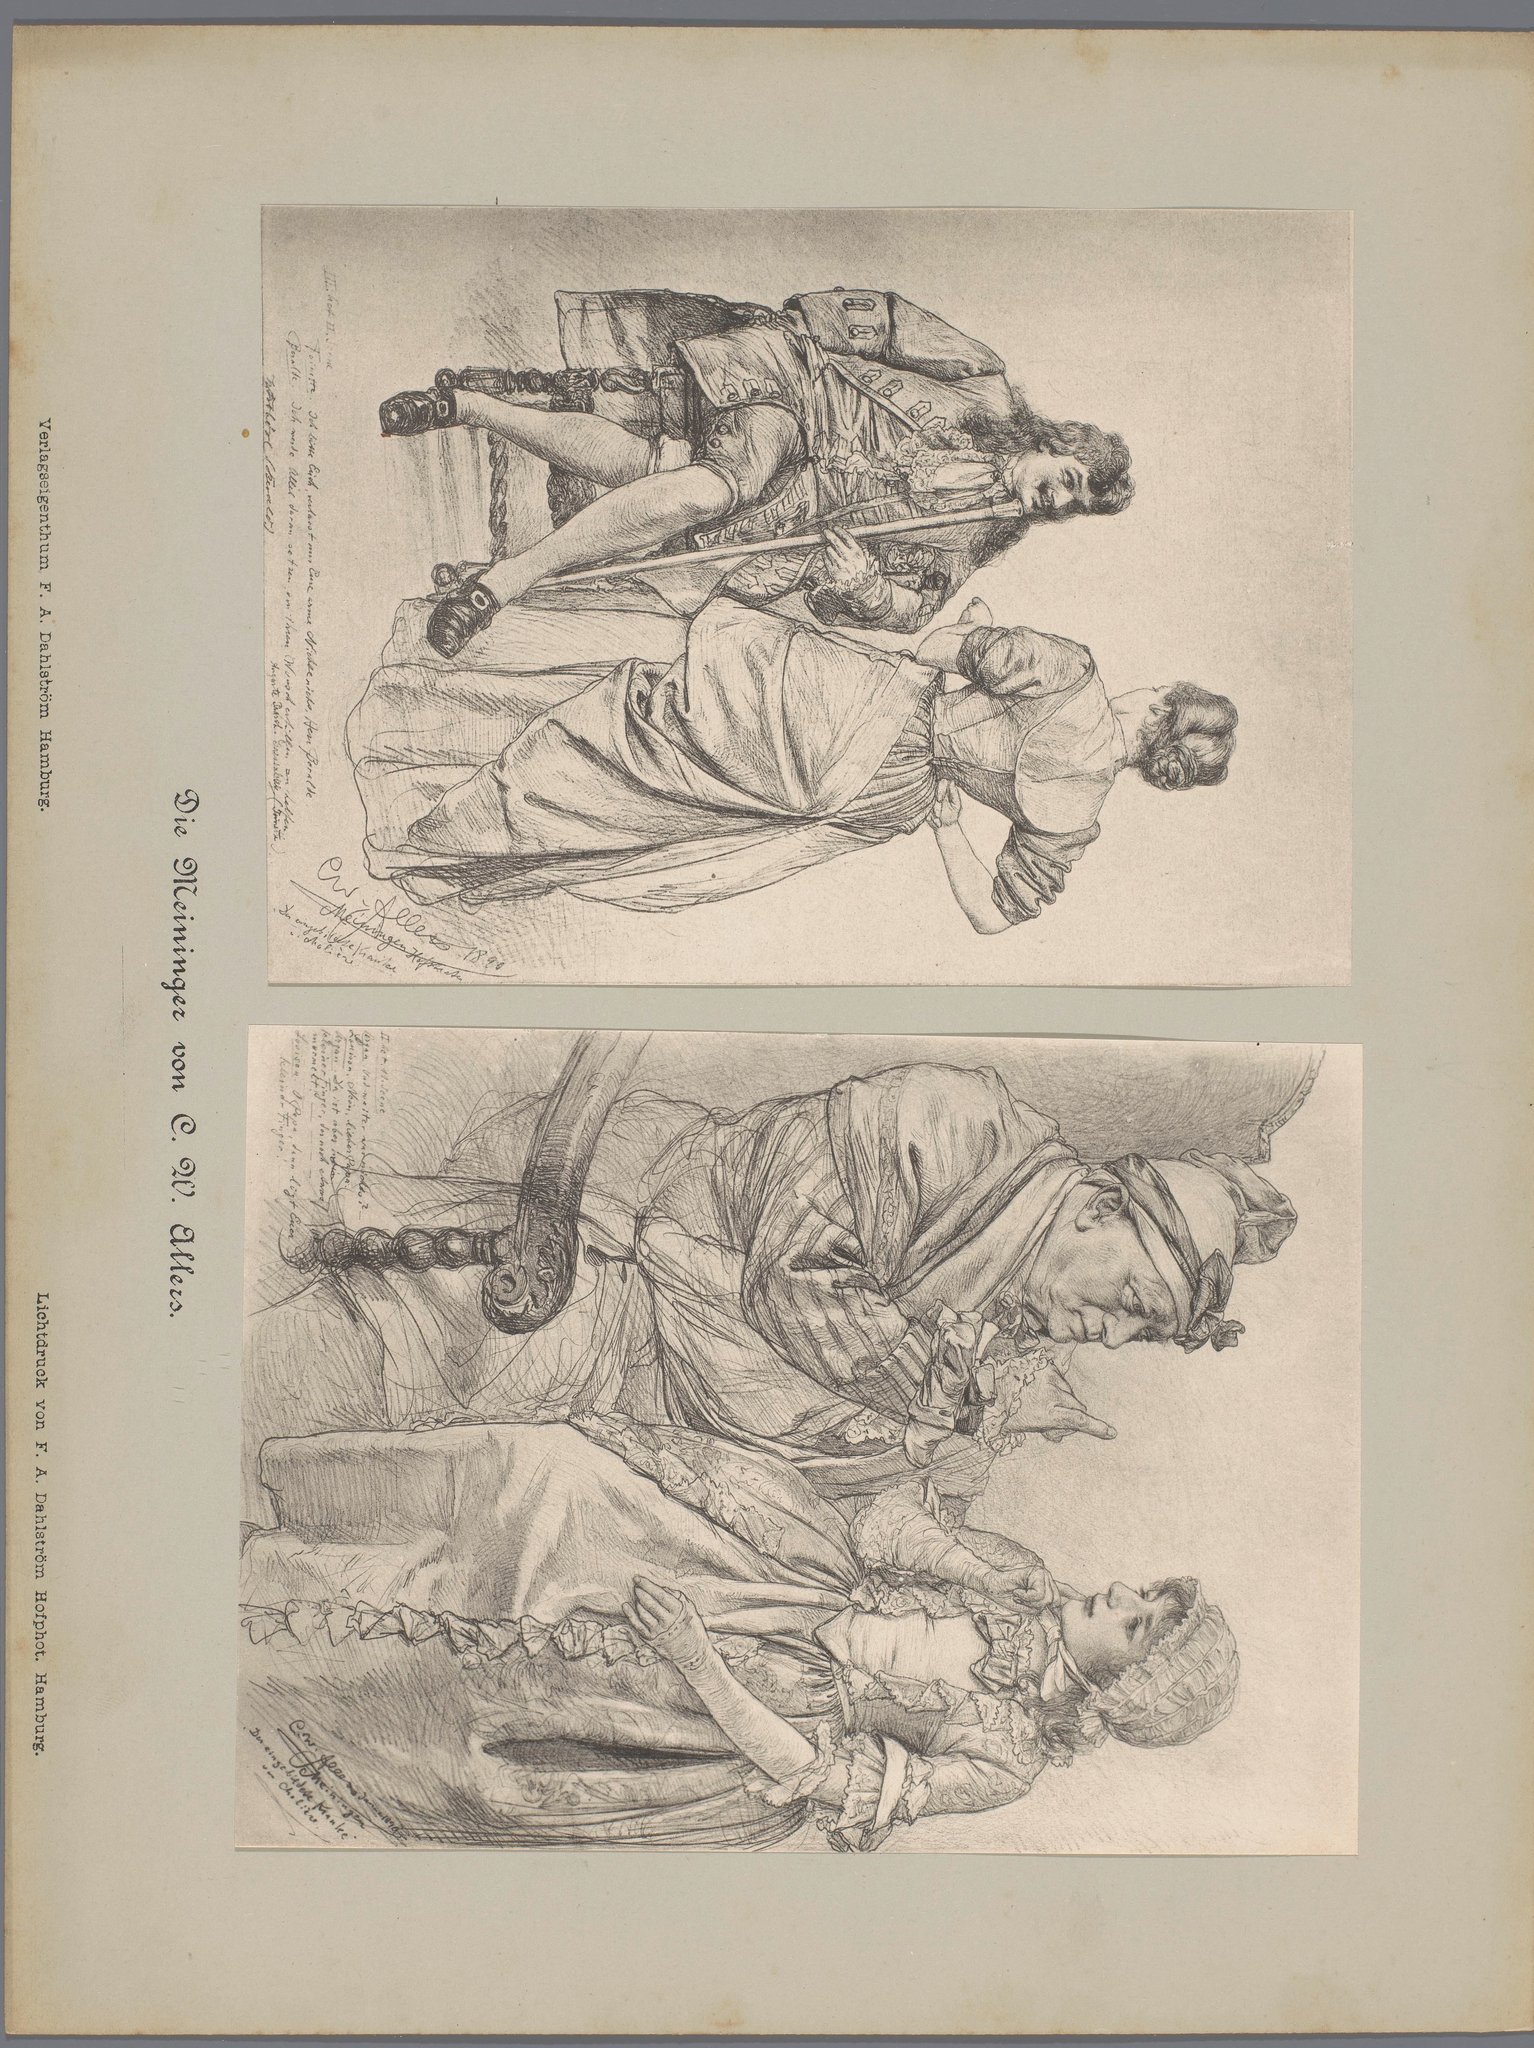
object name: reproduction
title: Die Meininger von C. W. Allers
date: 1890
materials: paper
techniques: photograph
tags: stage costume, portrait of actor, actress